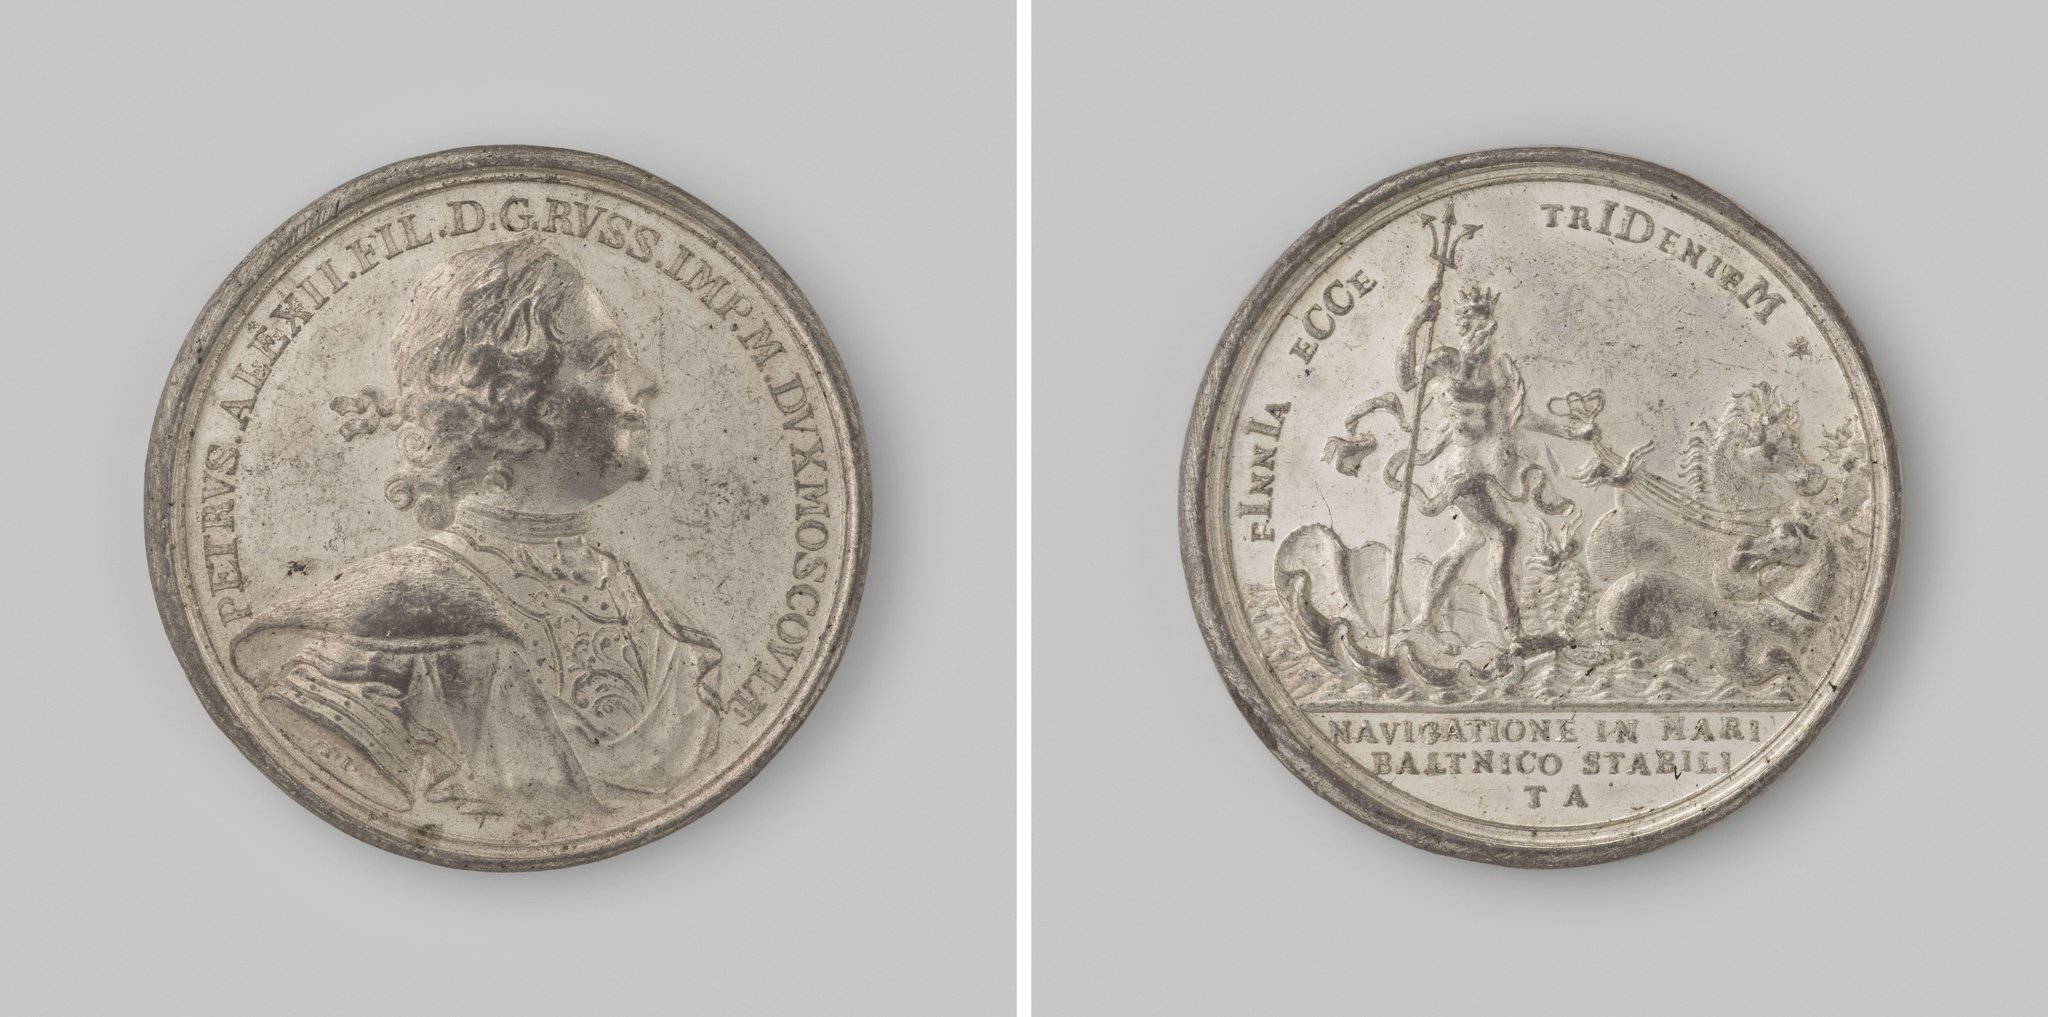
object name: history medal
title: Beheersing van de scheepvaart op de Oostzee door Rusland 1704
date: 1704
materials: tin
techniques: striking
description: Tinnen penning, op de voorzijde het borstbeeld van Tsaar Peter de Grote naar rechts met omschrift, op de keerzijde Neptunus in een schelp voortgetrokken door hippocampen, met omschrift en afsnedetekst.